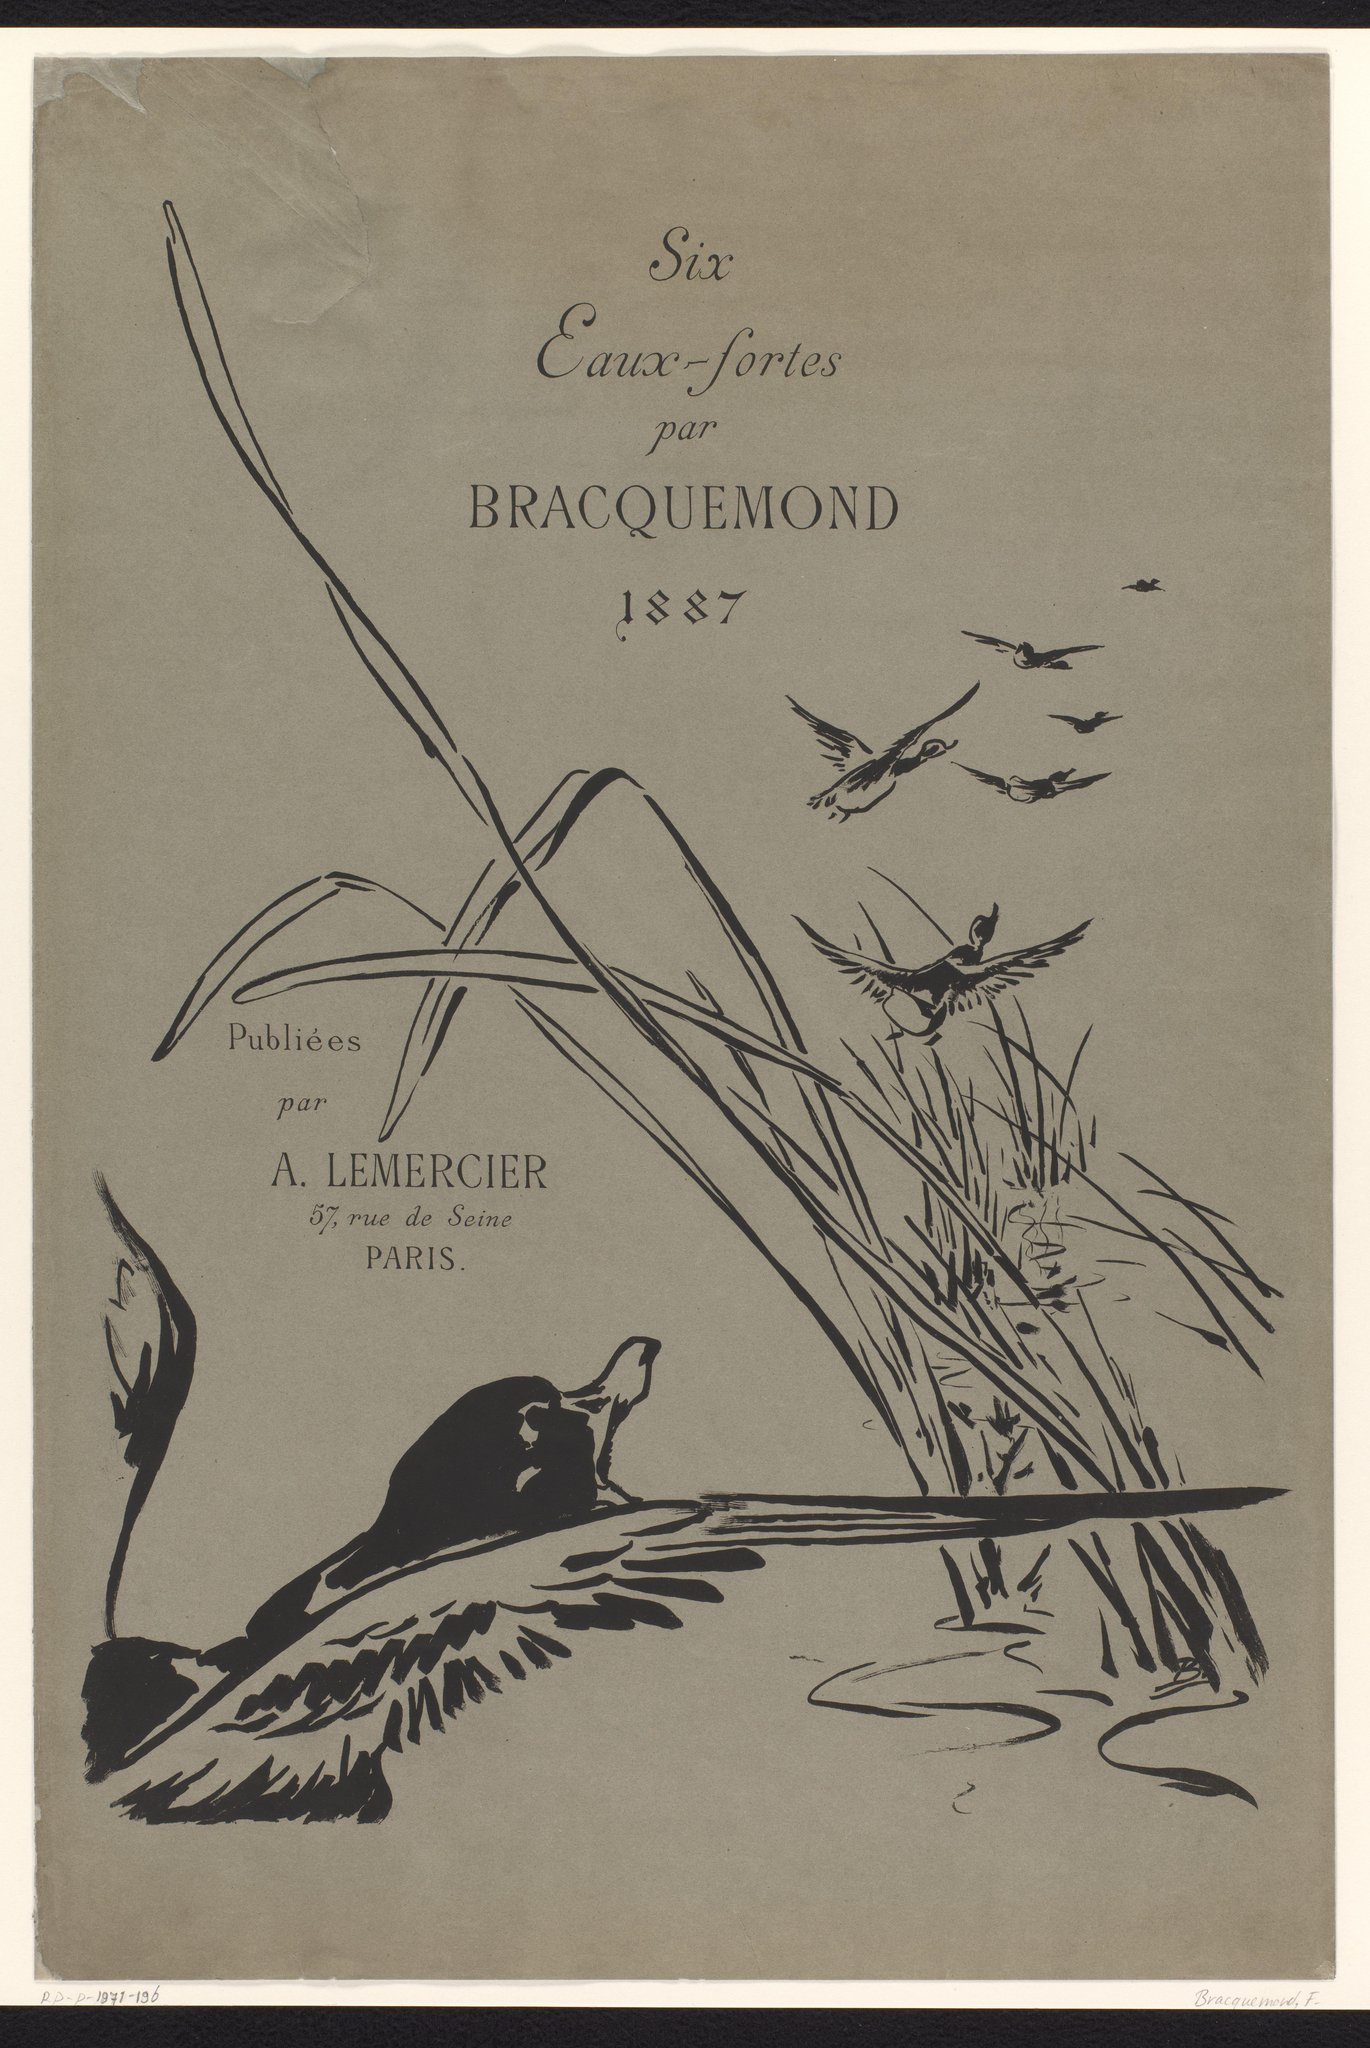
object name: wrapper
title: Omslag voor: Zes landschappen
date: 1887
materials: paper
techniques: pen lithography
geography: paris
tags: plants and herbs: reed, water-birds: duck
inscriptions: collector's mark: Lugt 2228a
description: Omslag voor zes landschapsetsen met diverse soorten vogels.